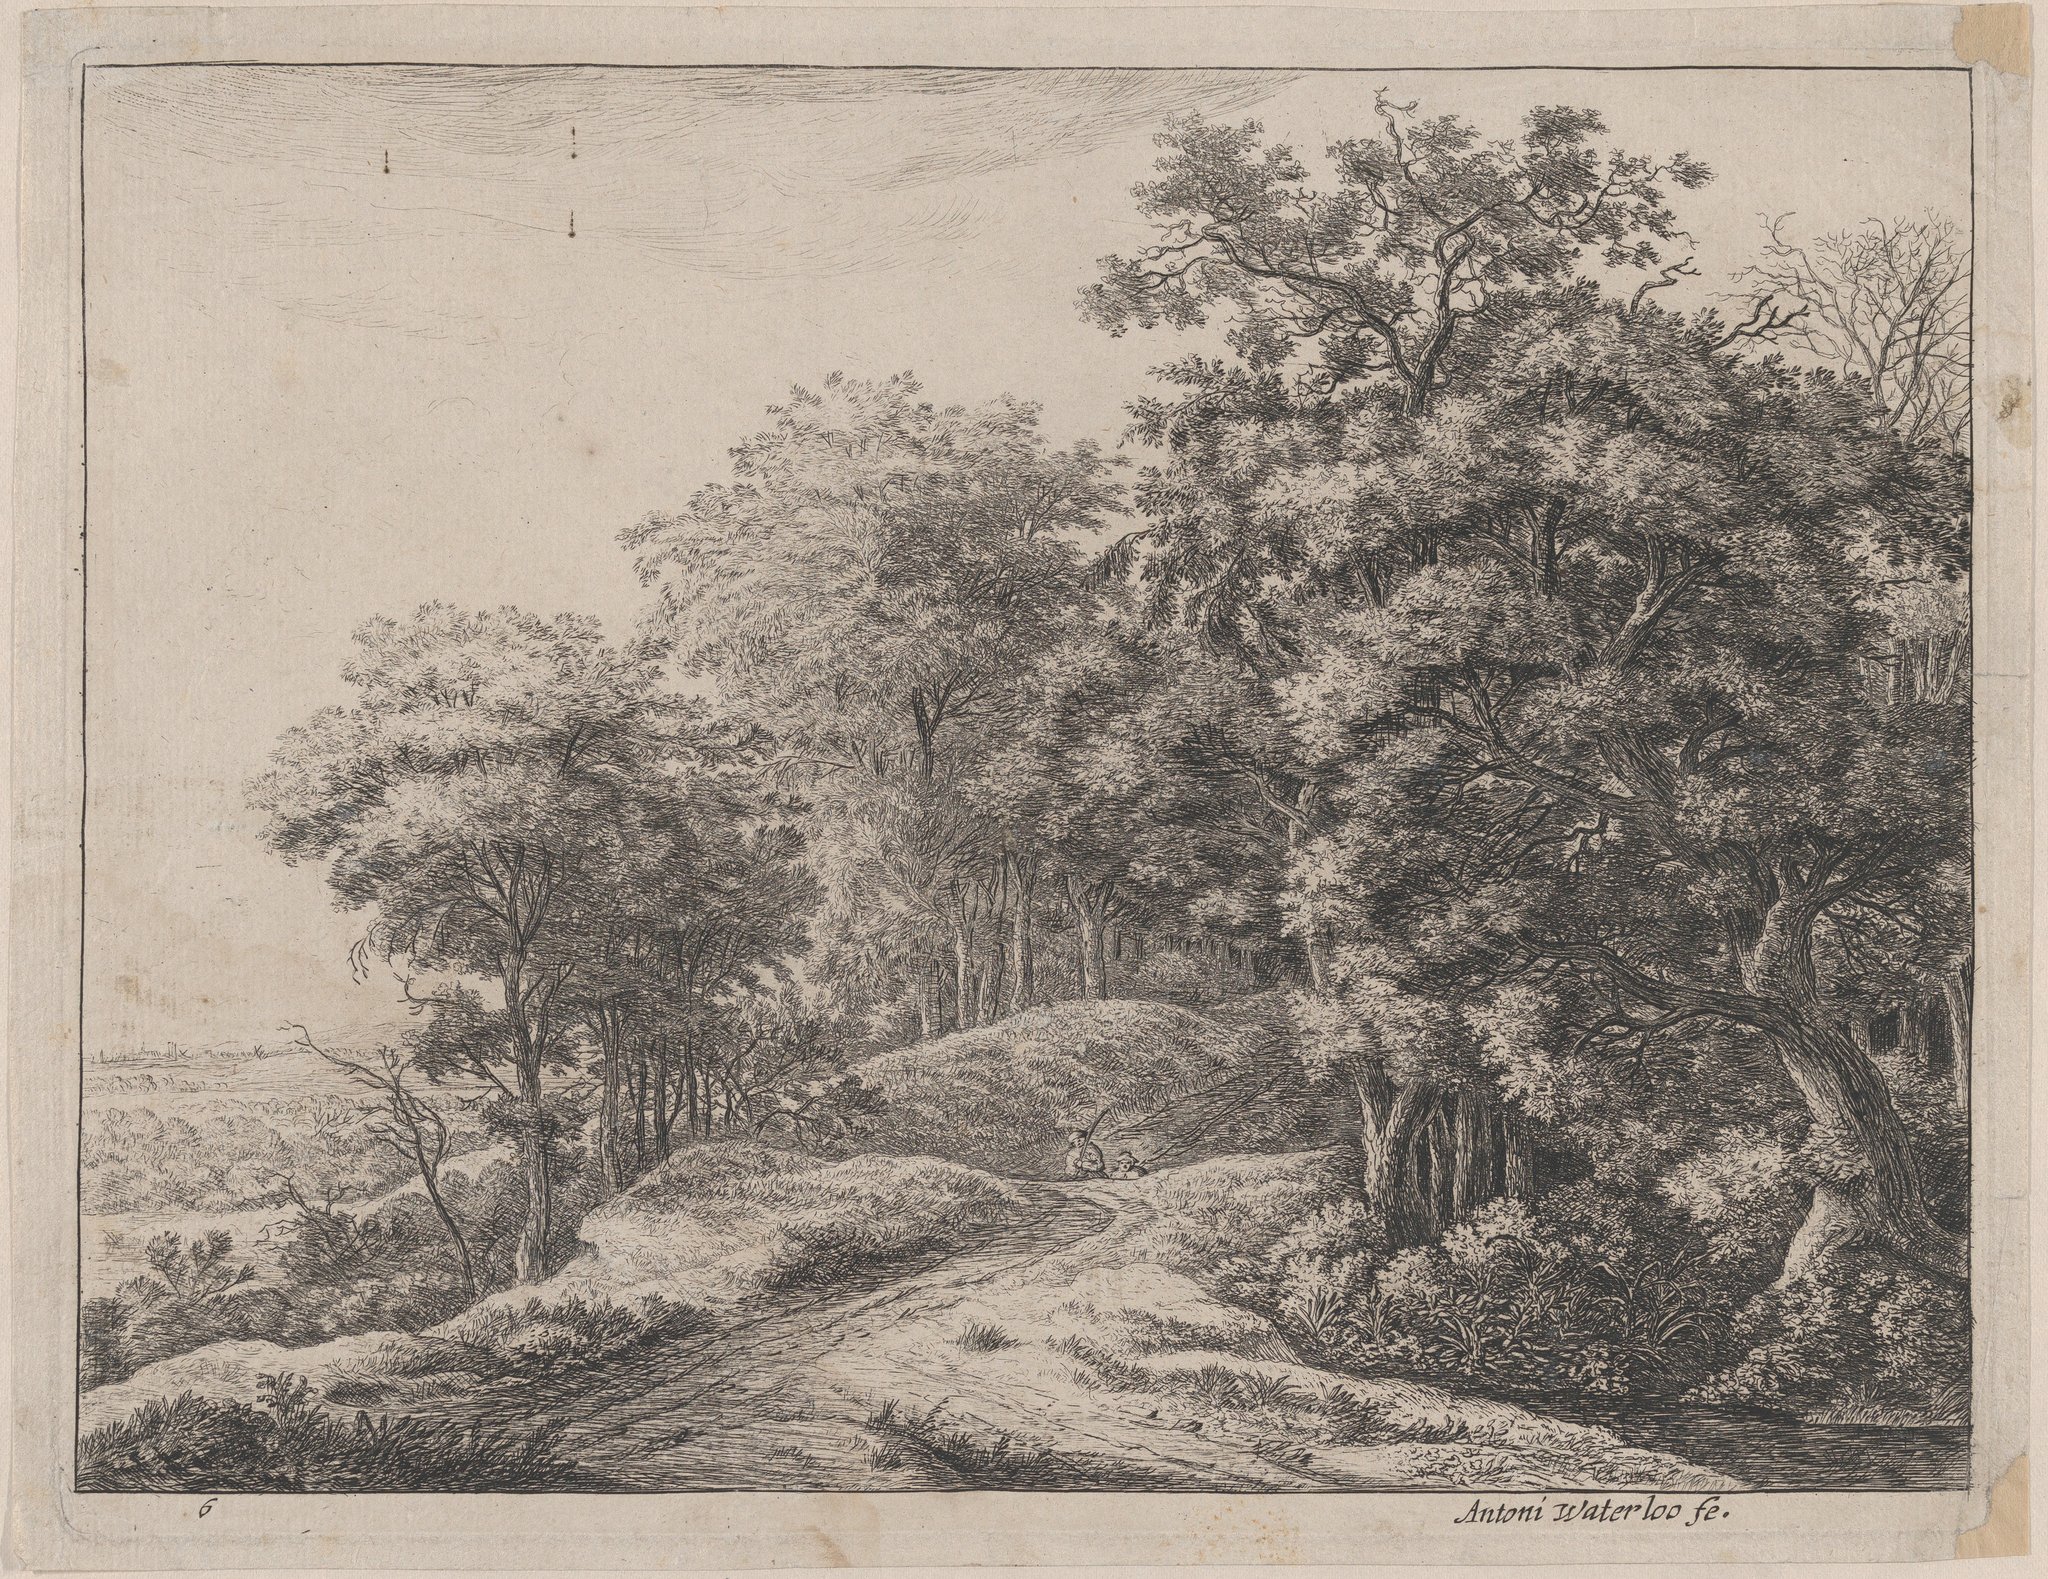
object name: print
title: Two Men in a Hollow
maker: anthonie waterloo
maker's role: artist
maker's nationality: dutch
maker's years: 1609-1690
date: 1601-1700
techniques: etching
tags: men,landscapes,trees